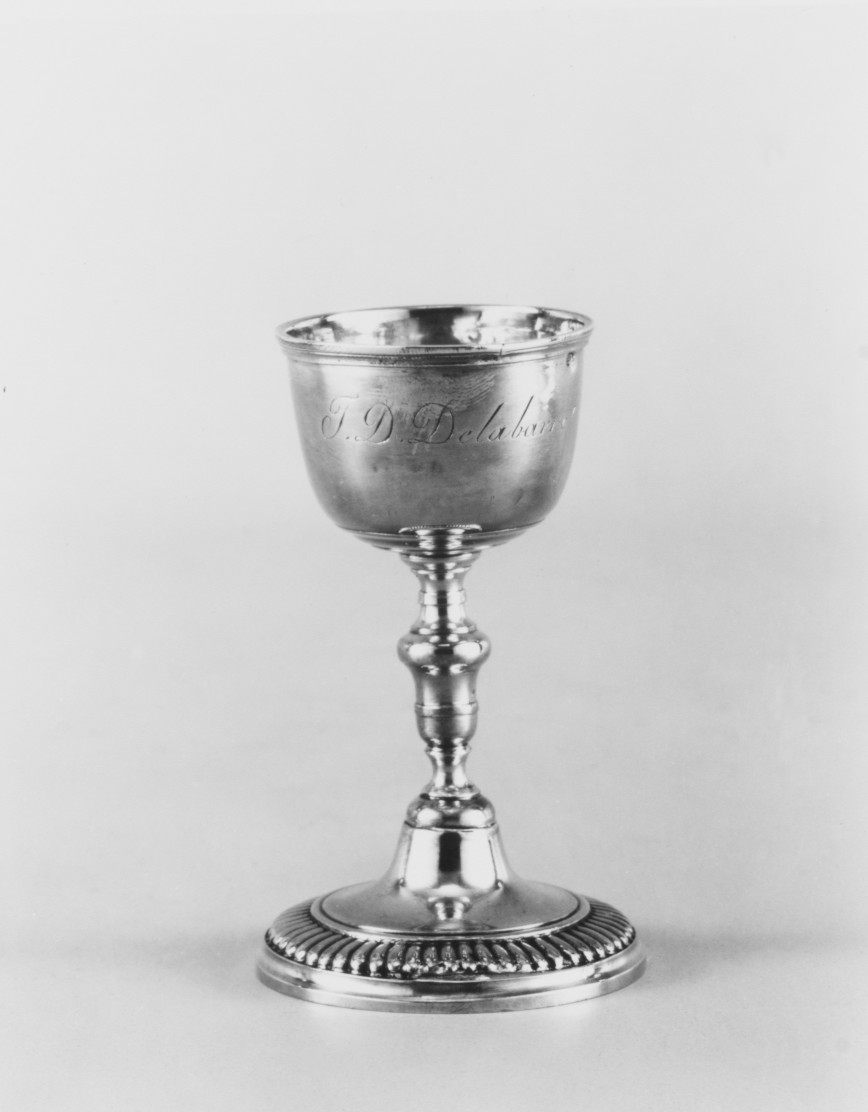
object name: egg cup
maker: nicolas haudry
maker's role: maker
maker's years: 1654-1754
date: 1724-1725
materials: silver